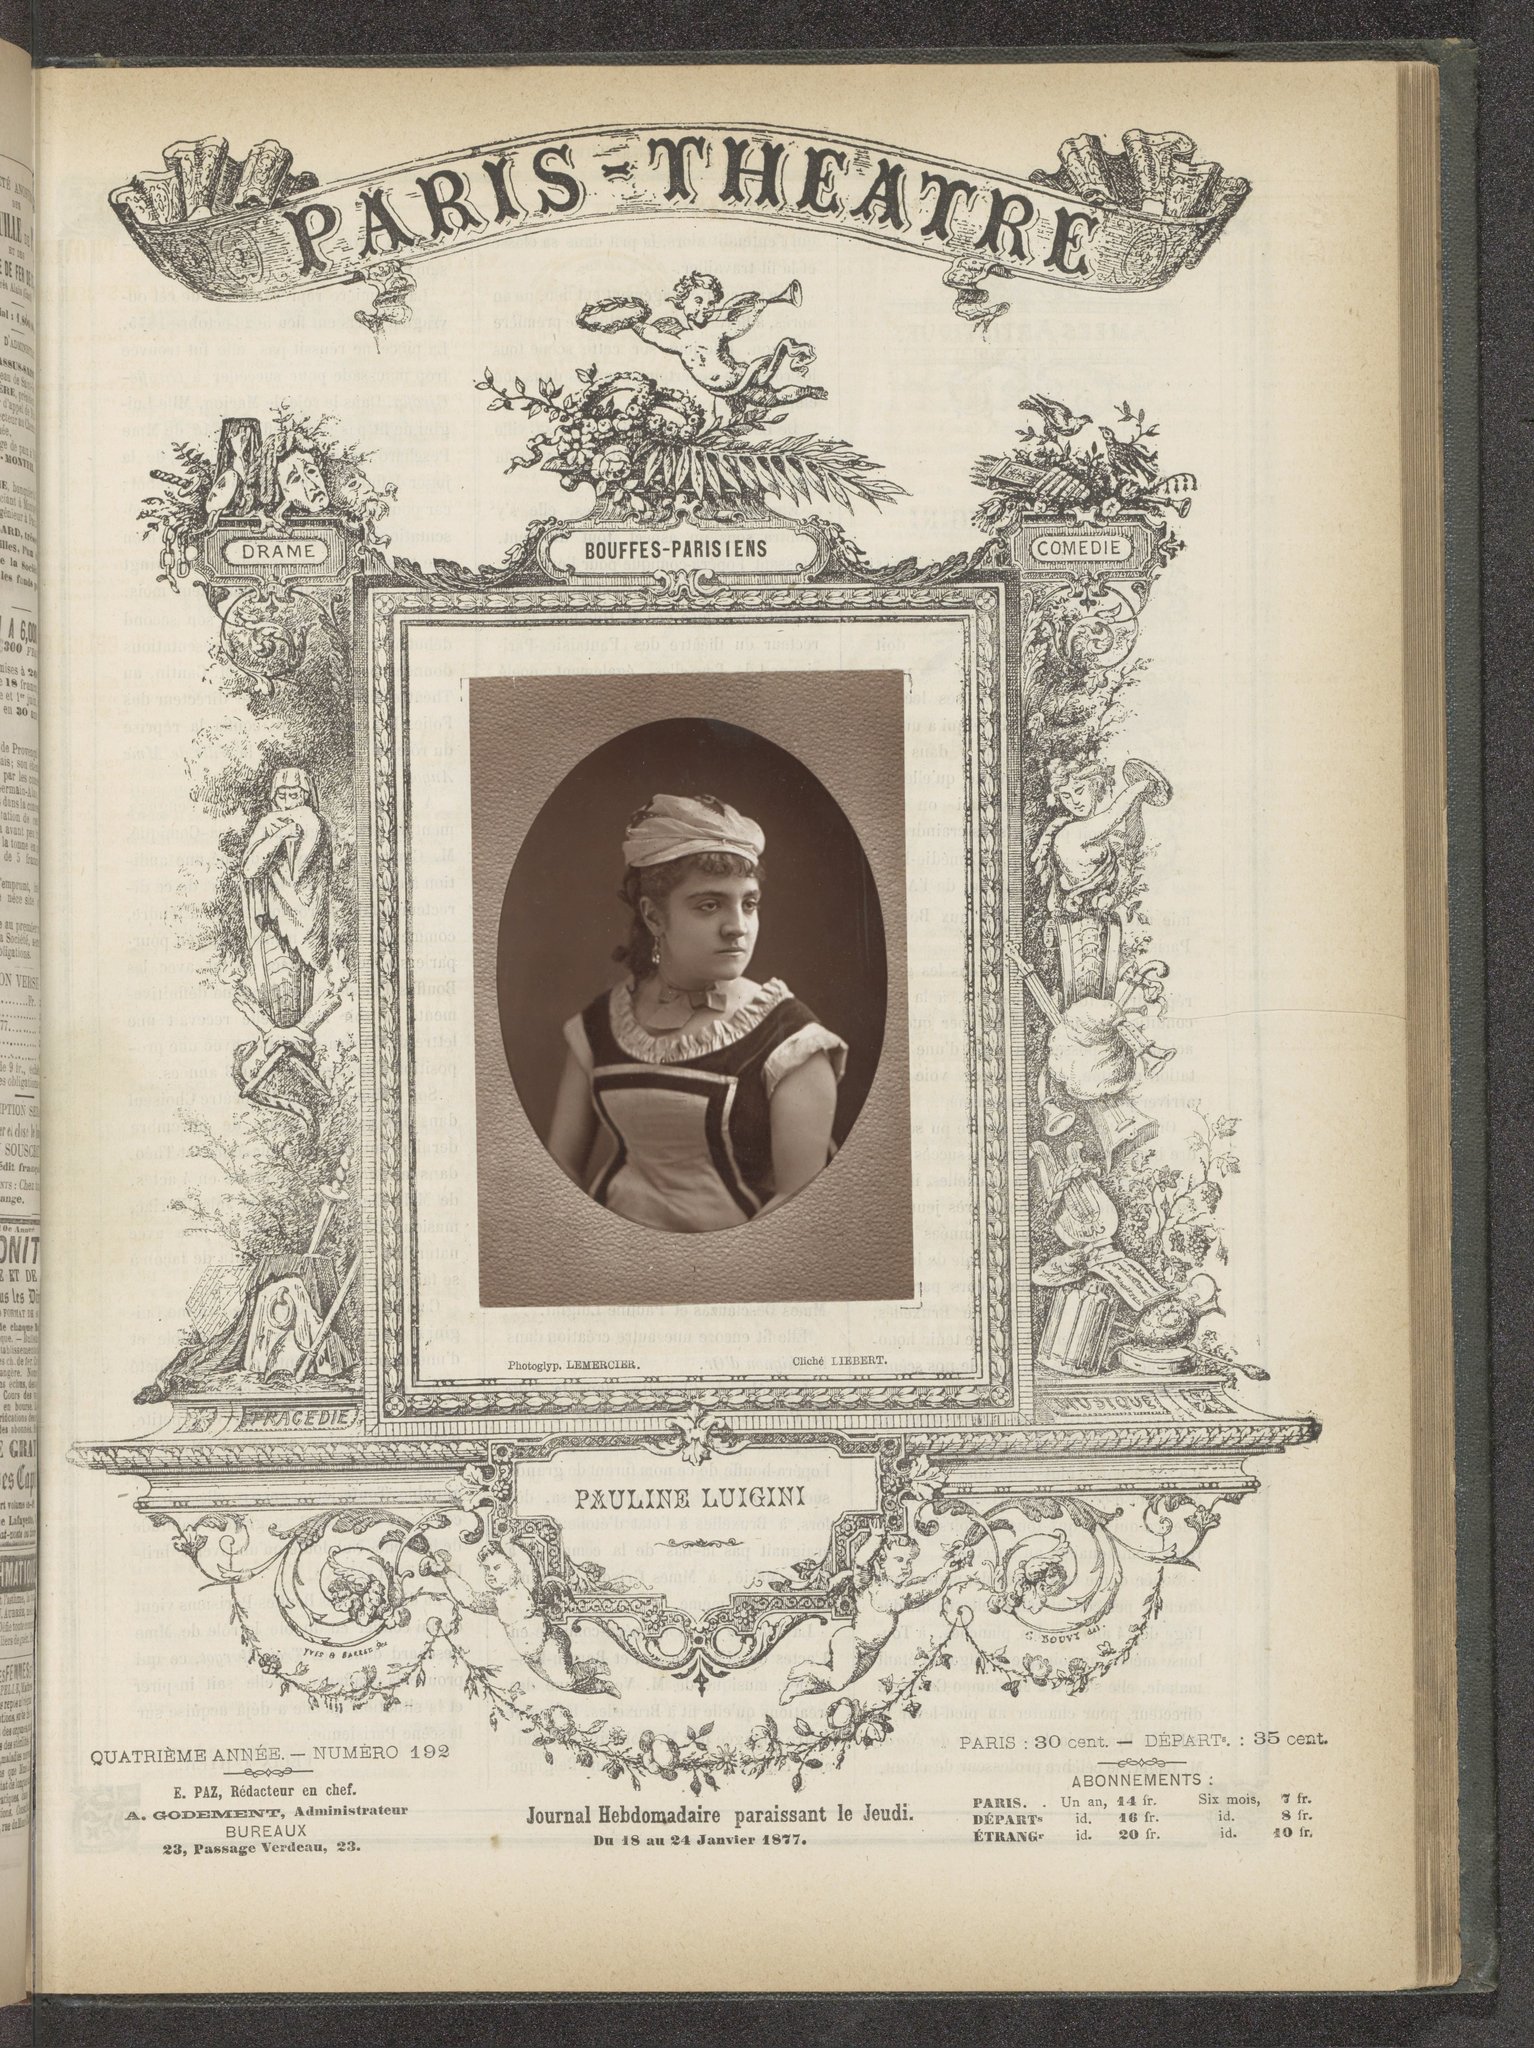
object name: photomechanical print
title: Portret van Pauline Luigini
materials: paper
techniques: woodburytype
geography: france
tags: portrait of opera-singer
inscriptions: inscription: ‘Journal Hebdomadaire paraissant le Jeudi, Du 18 au 24 Janvier 1877.’, number: ‘Numéro 192’